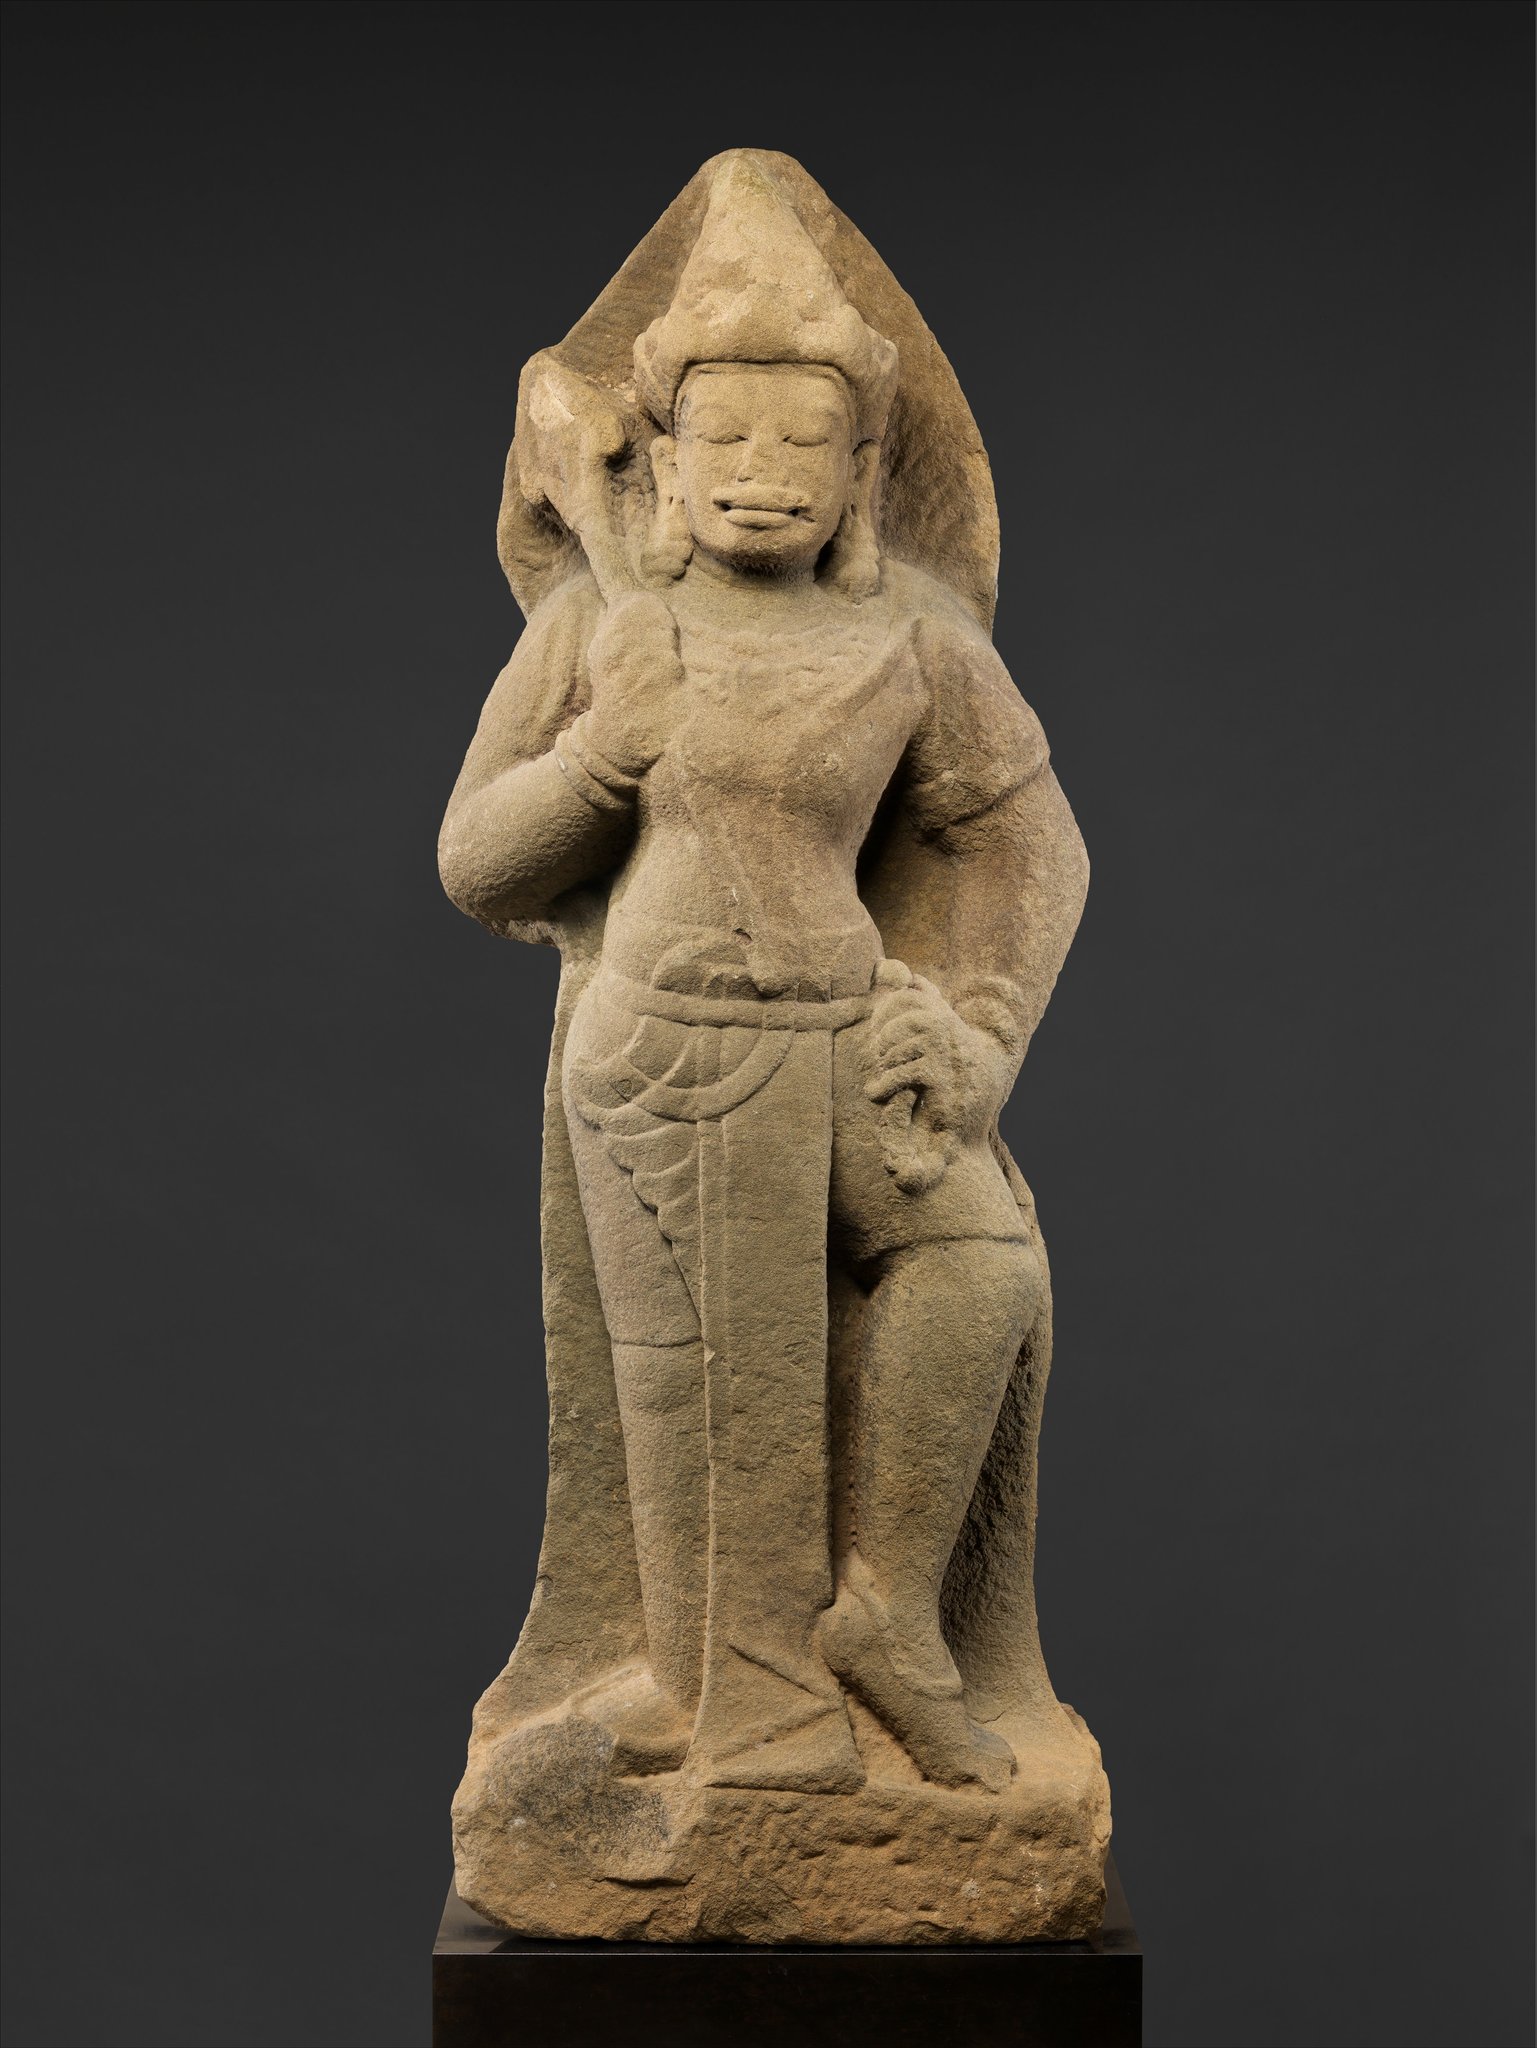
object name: figure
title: Standing Shiva or Temple Guardian (Dvarapala)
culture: vietnamese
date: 901-950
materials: stone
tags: shiva